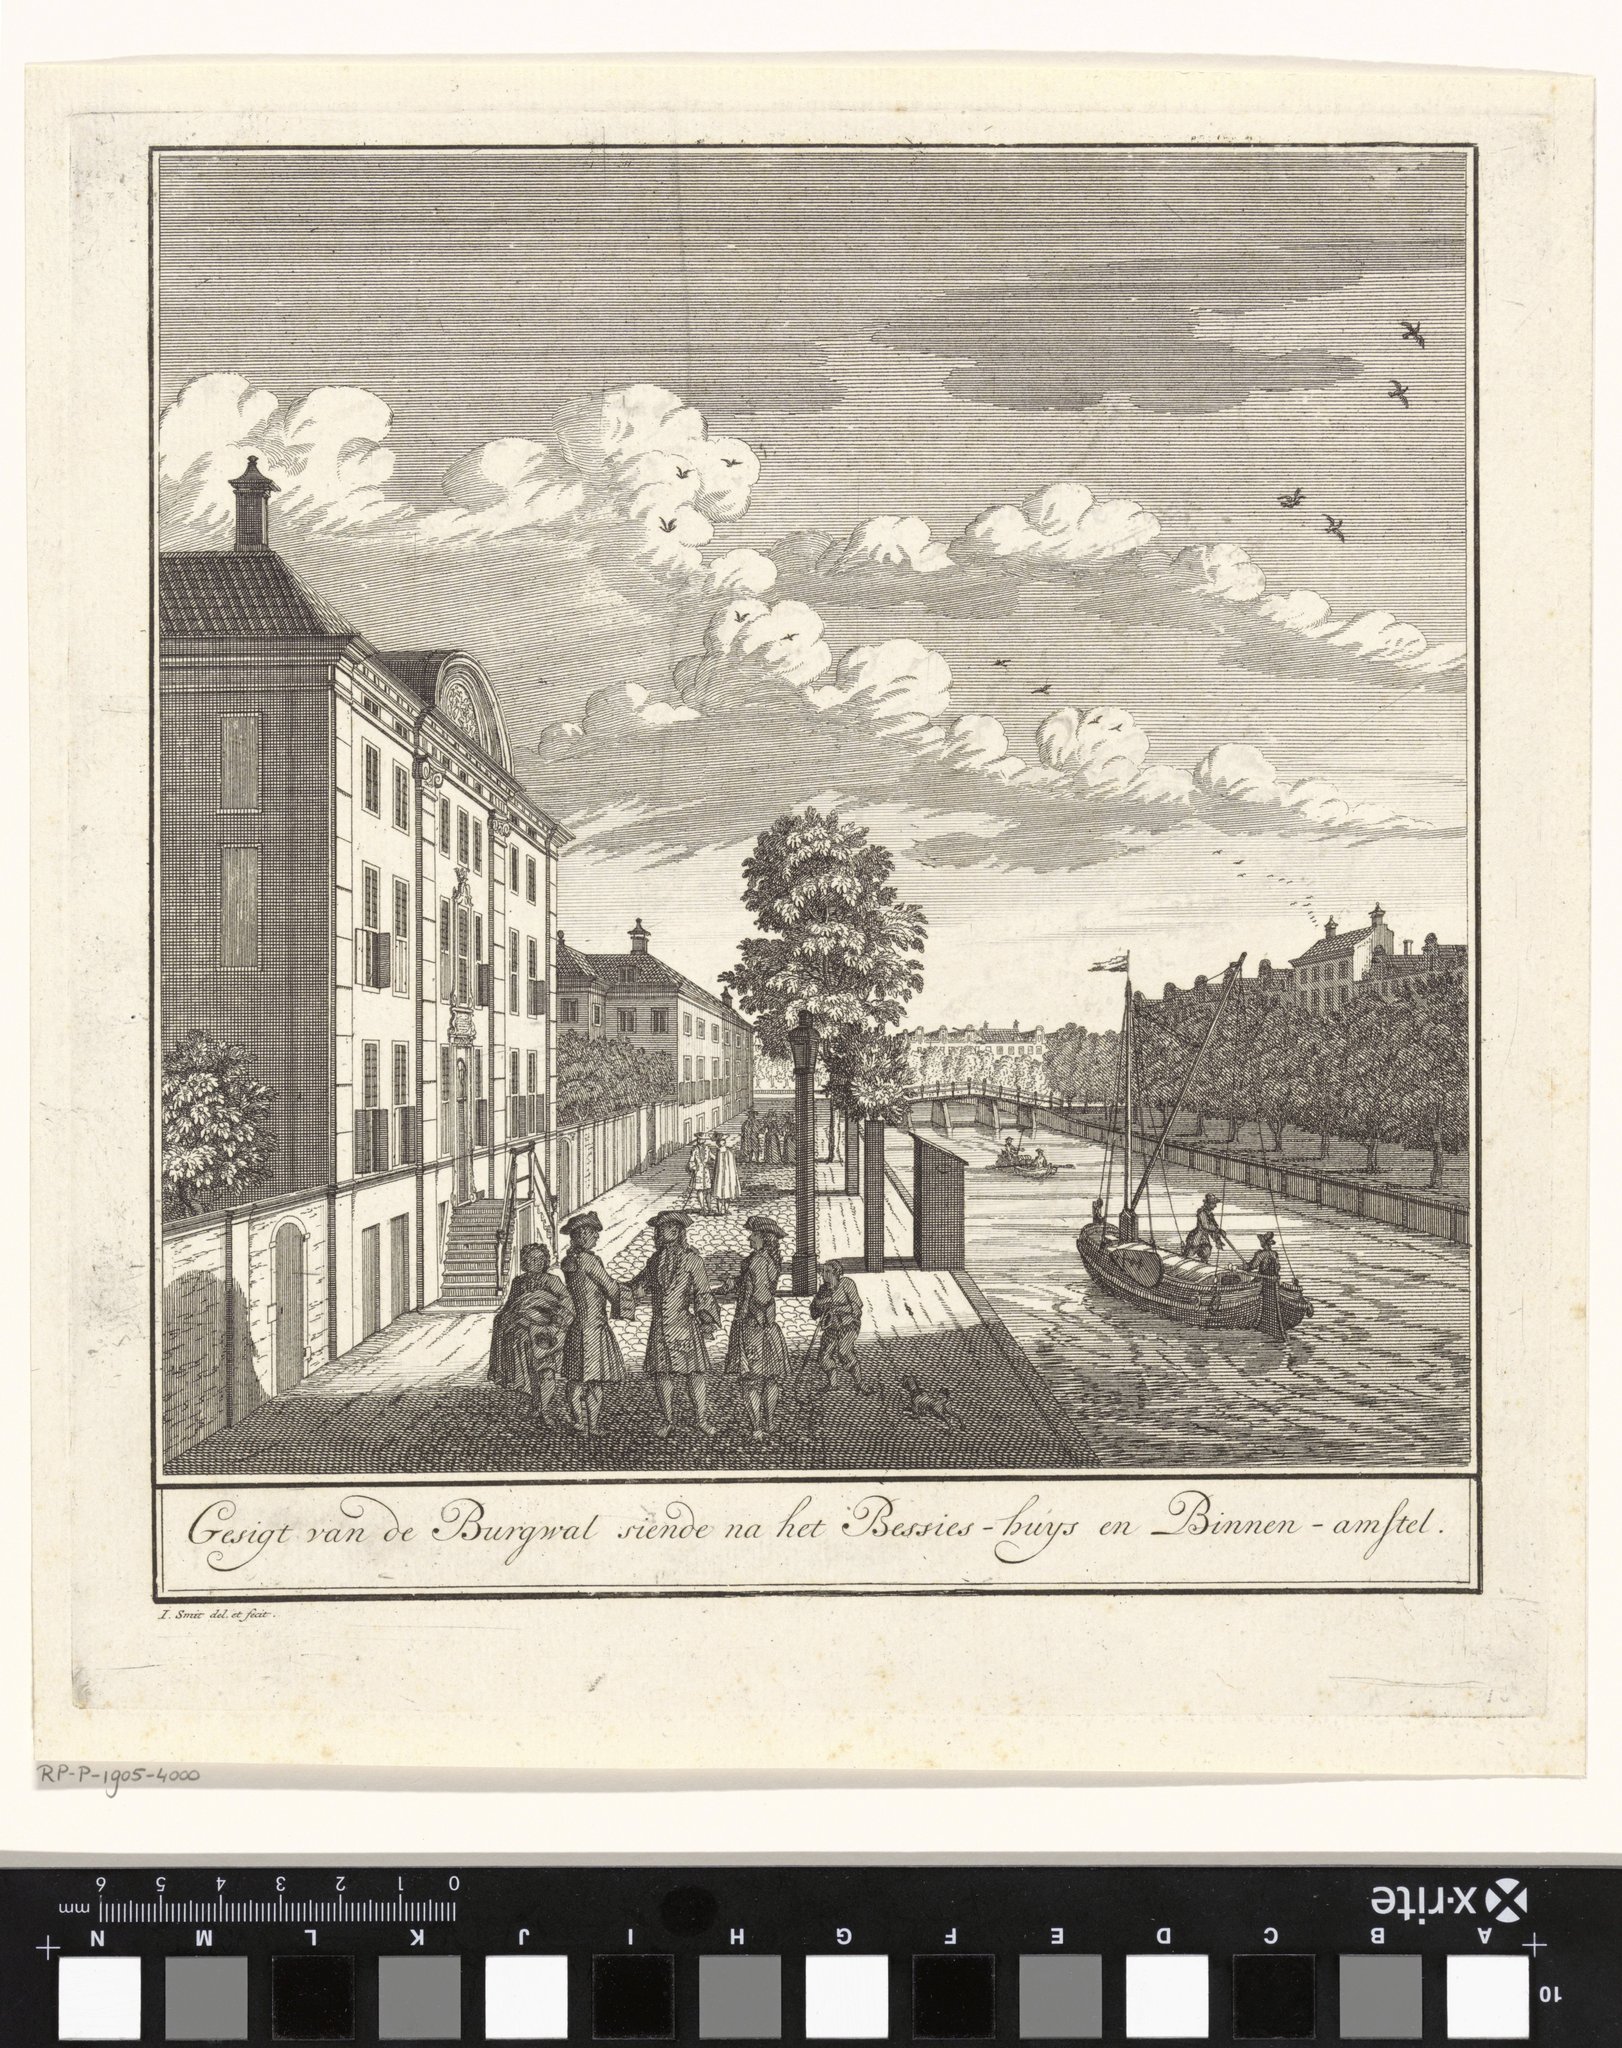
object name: print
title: Gezicht op het Corvershof te Amsterdam, gezien richting de Binnen-Amstel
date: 1723-1748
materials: paper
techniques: engraving, etching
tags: alms-house (dutch: 'hofje'), public welfare, bridge in city across river, canal, etc., canals, waters (in city) (+ city(-scape) with figures, staffage), old-people's home, street (+ city(-scape) with figures, staffage)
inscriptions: collector's mark: Lugt 2228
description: Gezicht op het Corvershof (links) aan de Nieuwe Herengracht te Amsterdam. Gezien richting de Binnen-Amstel, met links op de achtergrond een stuk van het Diaconie Oude Vrouwen- en Mannenhuis. Op straat staan groepjes pratende mensen. Onderdeel van een serie prenten van het in 1723 in gebruik genomen Corvershof, bestemd voor oudere echtparen van Nederduits Gereformeerde (later Hervormde) huize.